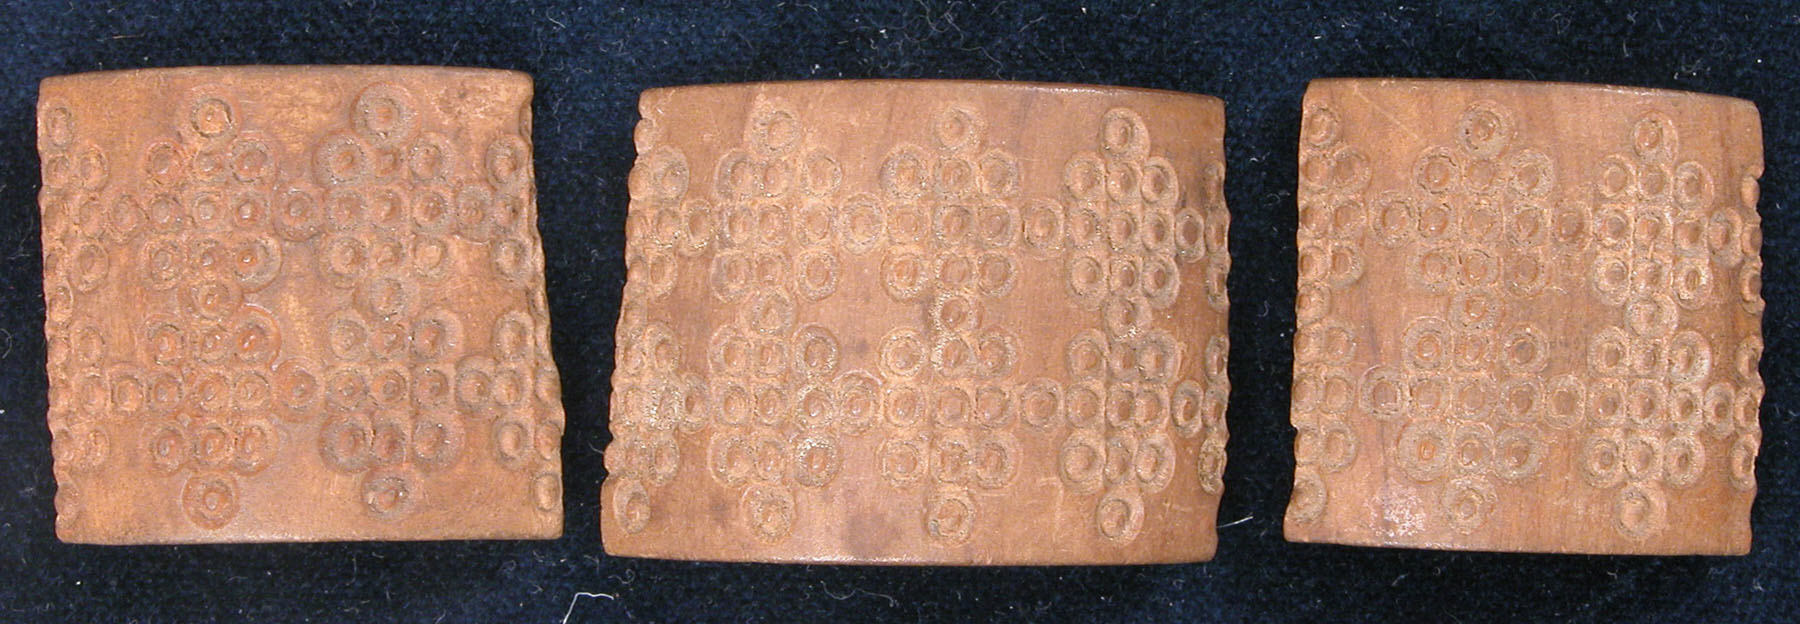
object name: bracelet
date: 201-1200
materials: wood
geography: egypt